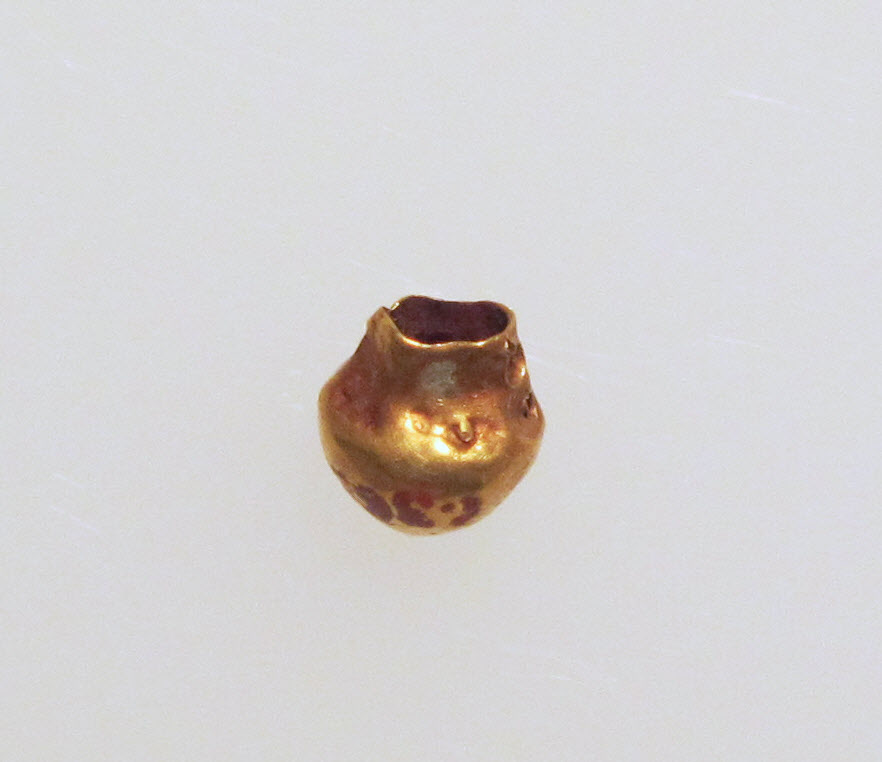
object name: pendant in the form of a vase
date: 7000 BCE-330 CE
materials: gold